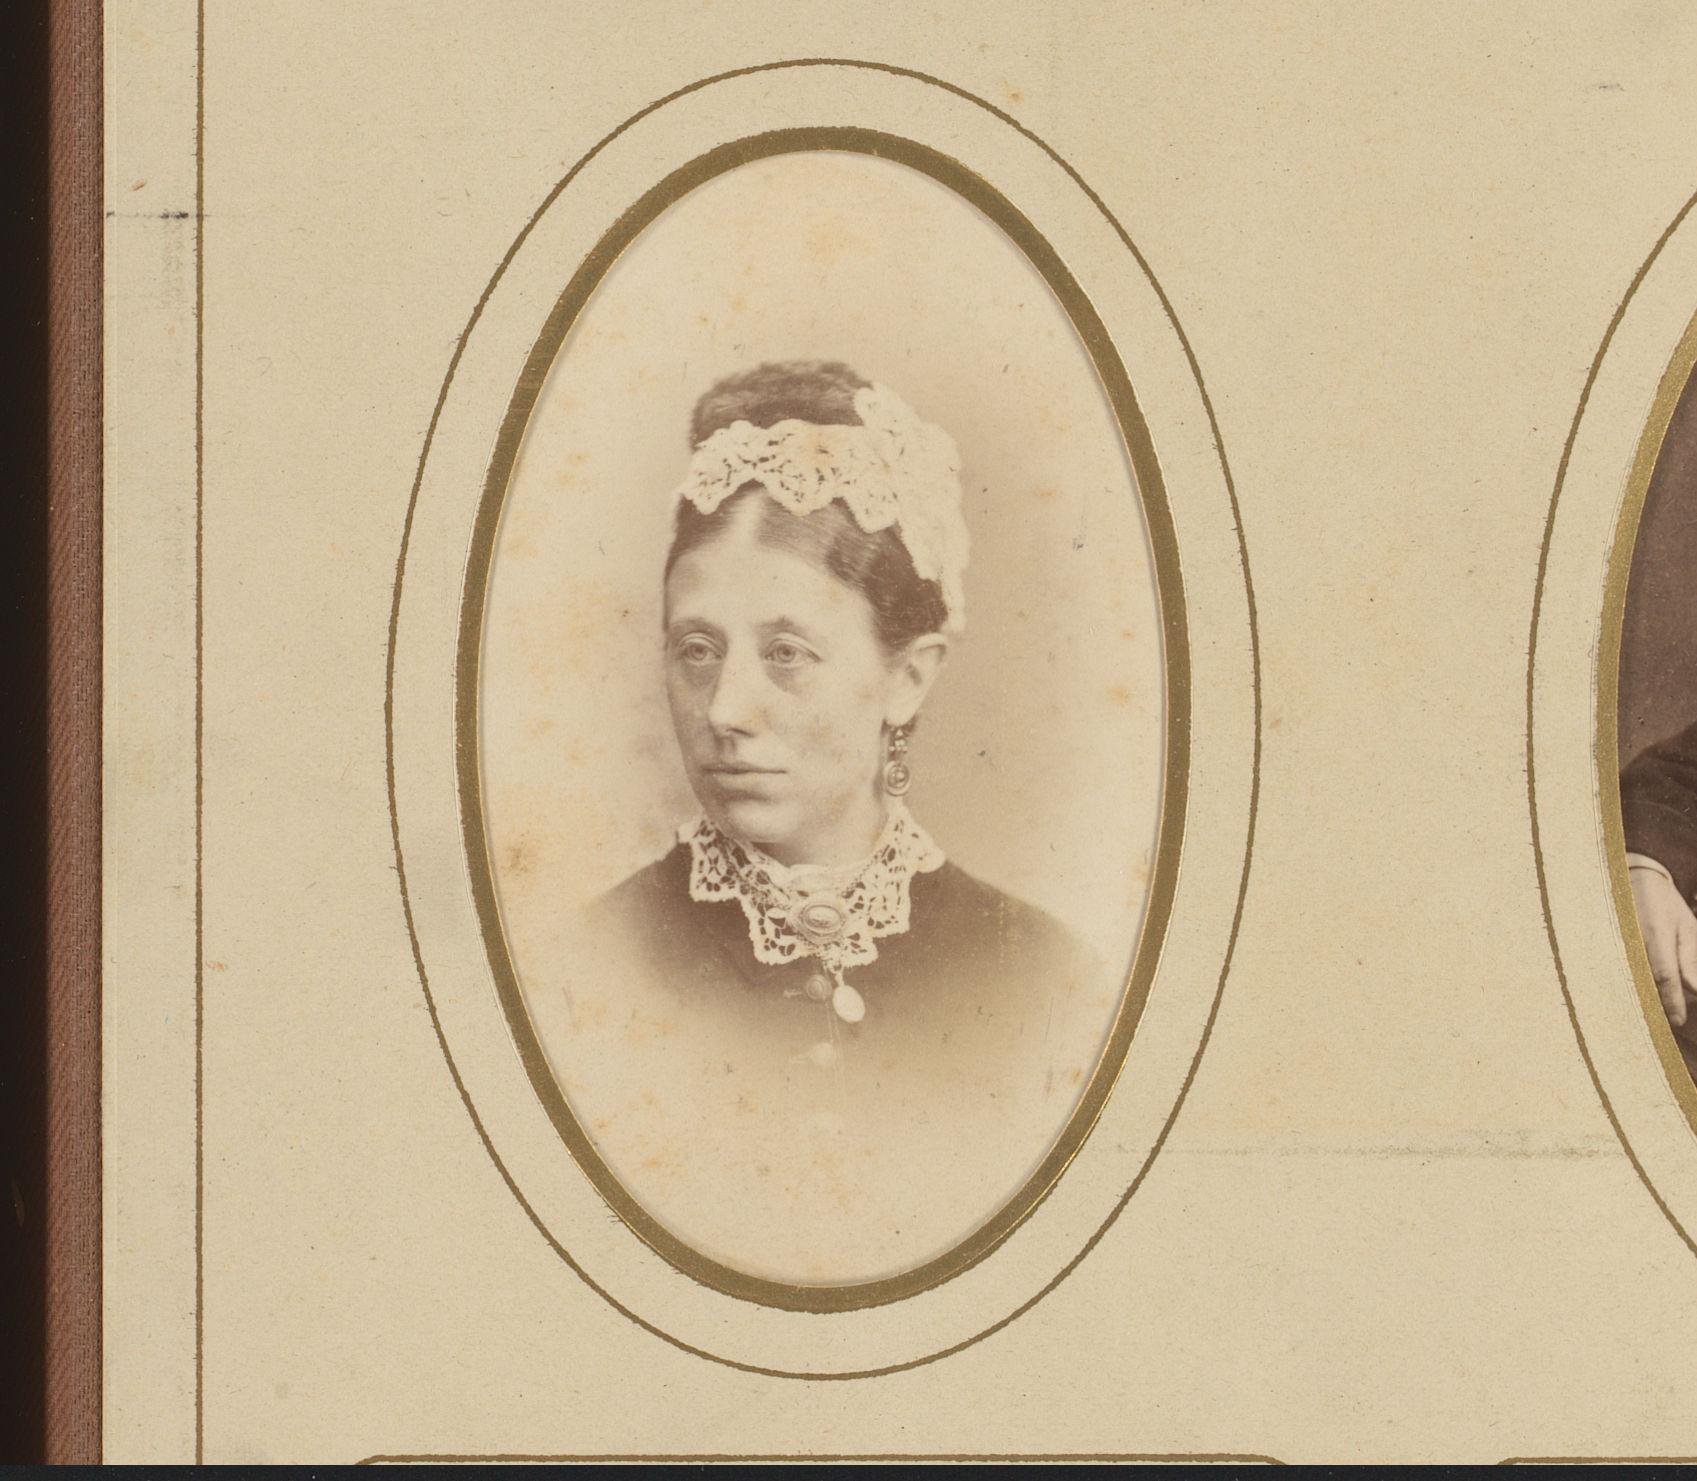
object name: carte de visite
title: Portret van een vrouw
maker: albert eugene fradelle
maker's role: fotograaf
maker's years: 1840-1884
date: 1878-1884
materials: cardboard, photographic support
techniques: albumen print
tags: adult woman, historical persons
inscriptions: inscription: ‘National Photot-Mezzo-Tint Galery/ Fradelle/ Portrat Painter Photography/ 246 Regent Street/ London’